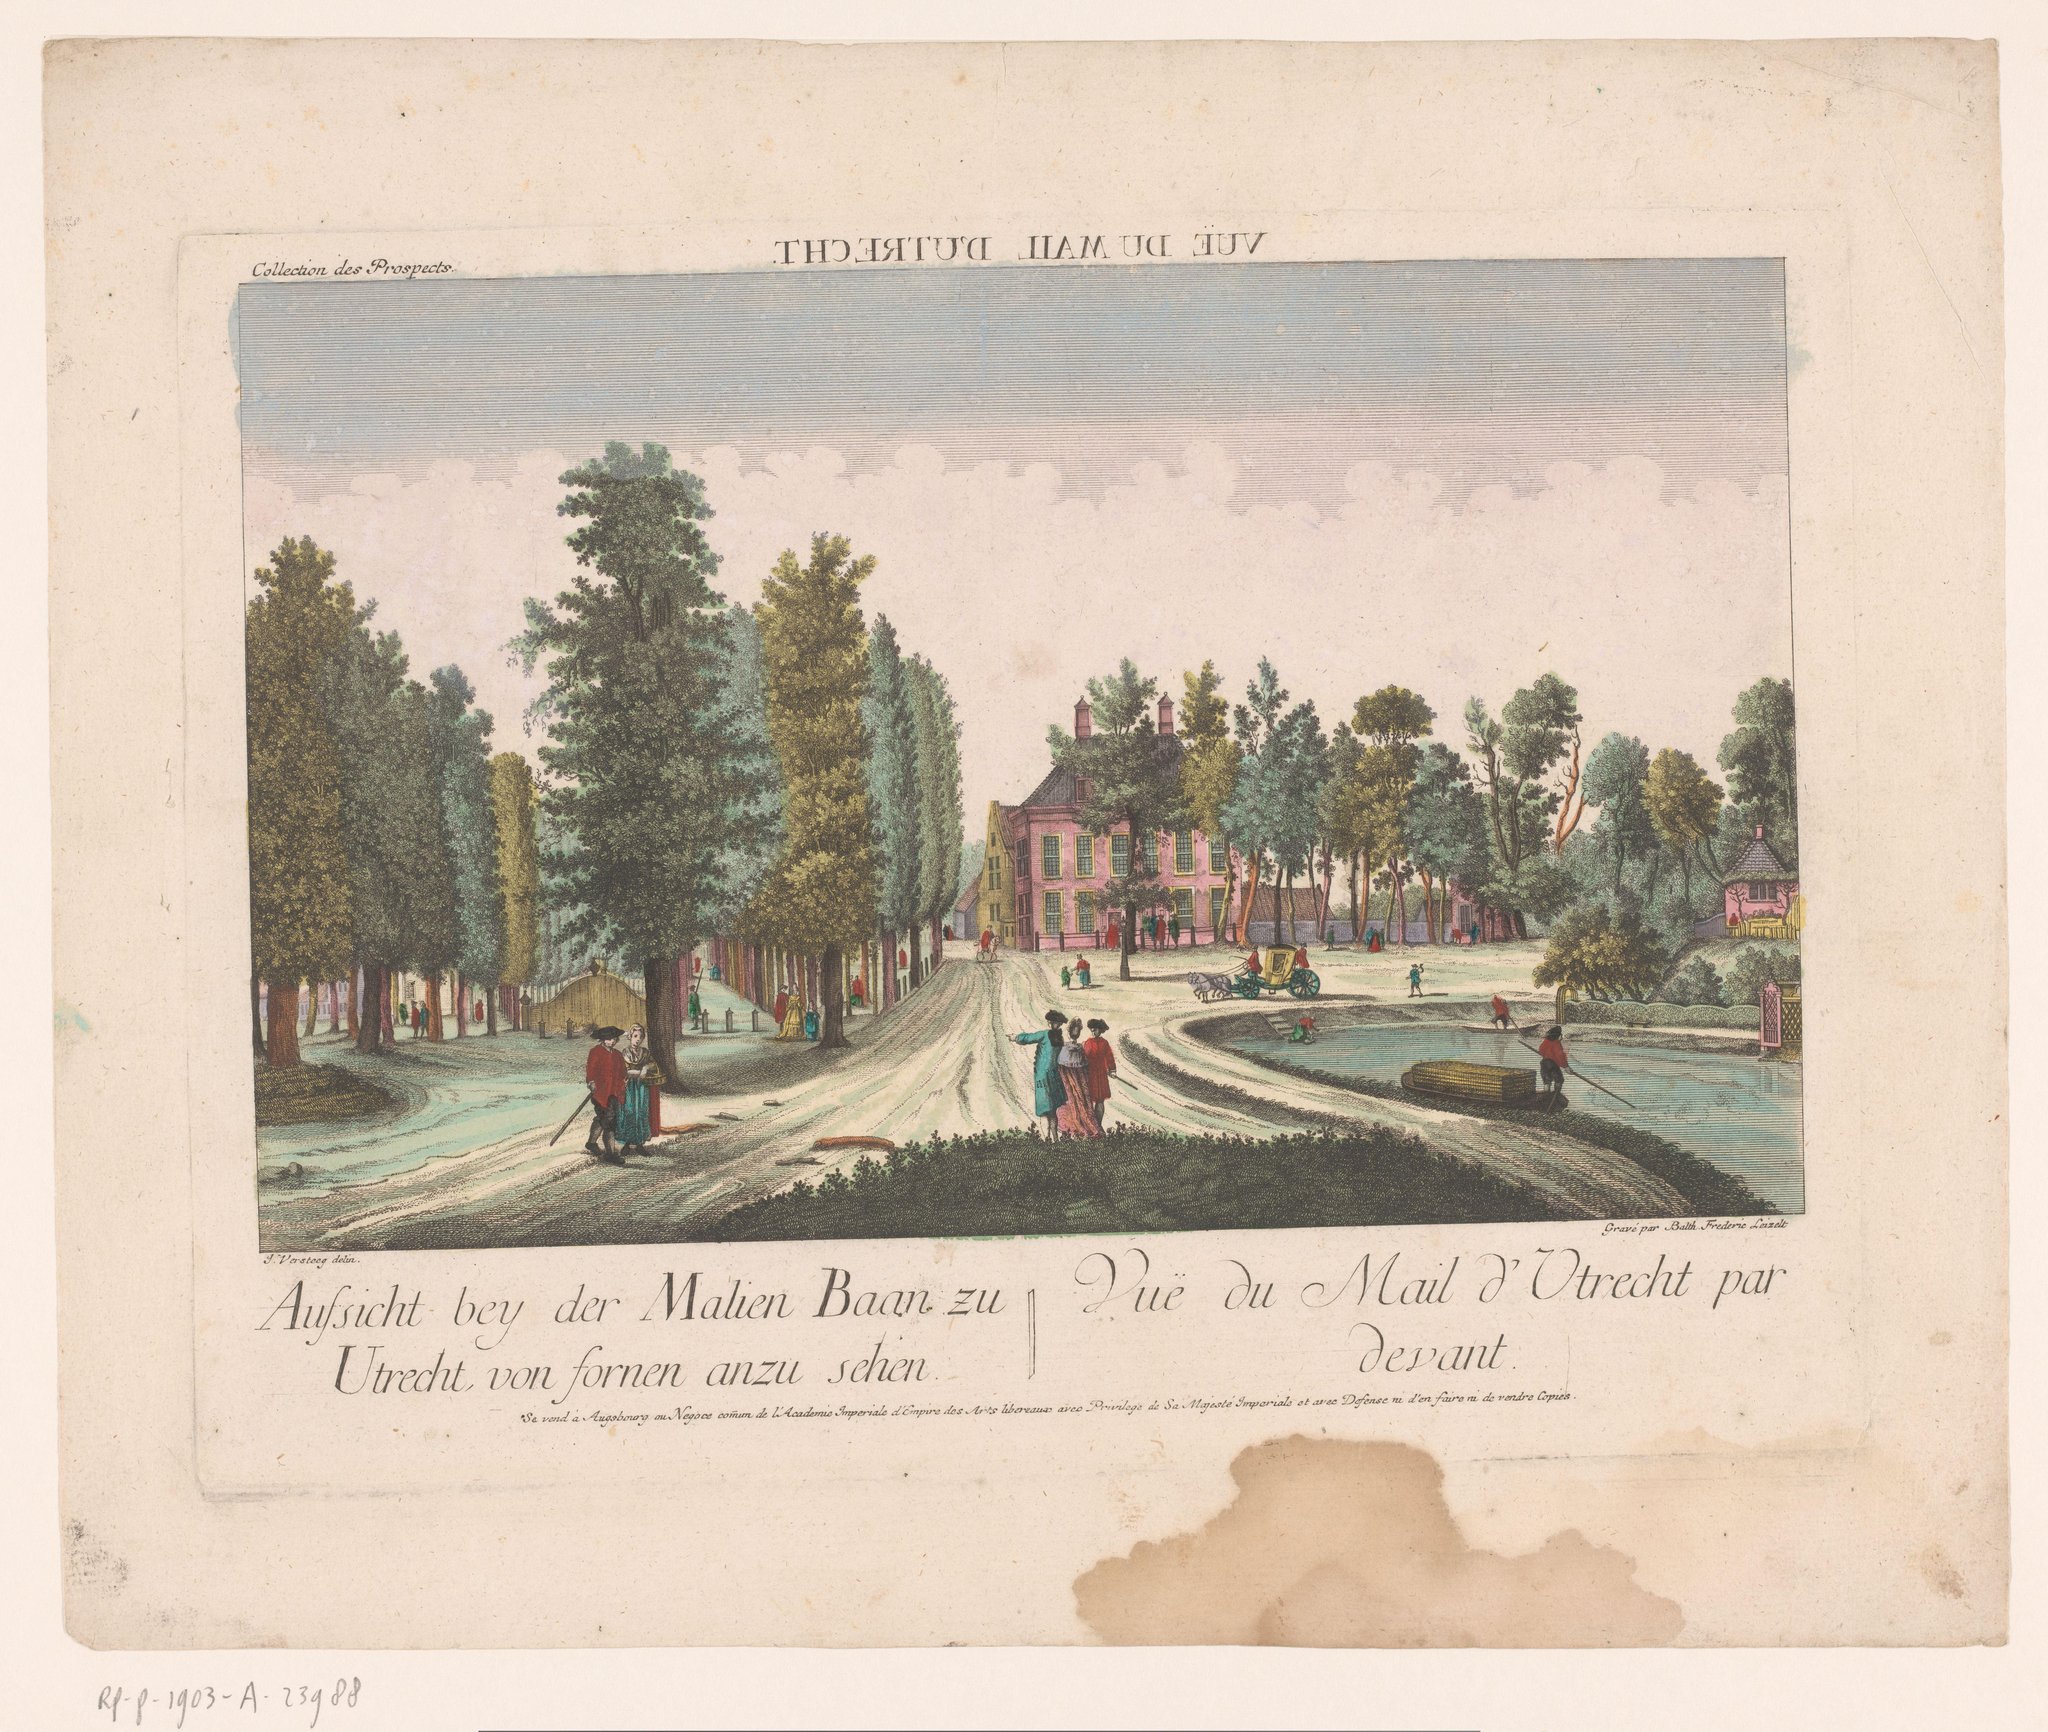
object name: opticaprent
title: Gezicht op de Maliebaan te Utrecht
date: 1755-1779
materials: paper, watercolor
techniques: brush, etching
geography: augsburg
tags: city-view in general; 'veduta', monumental adornments (in city)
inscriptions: collector's mark: Lugt 2228